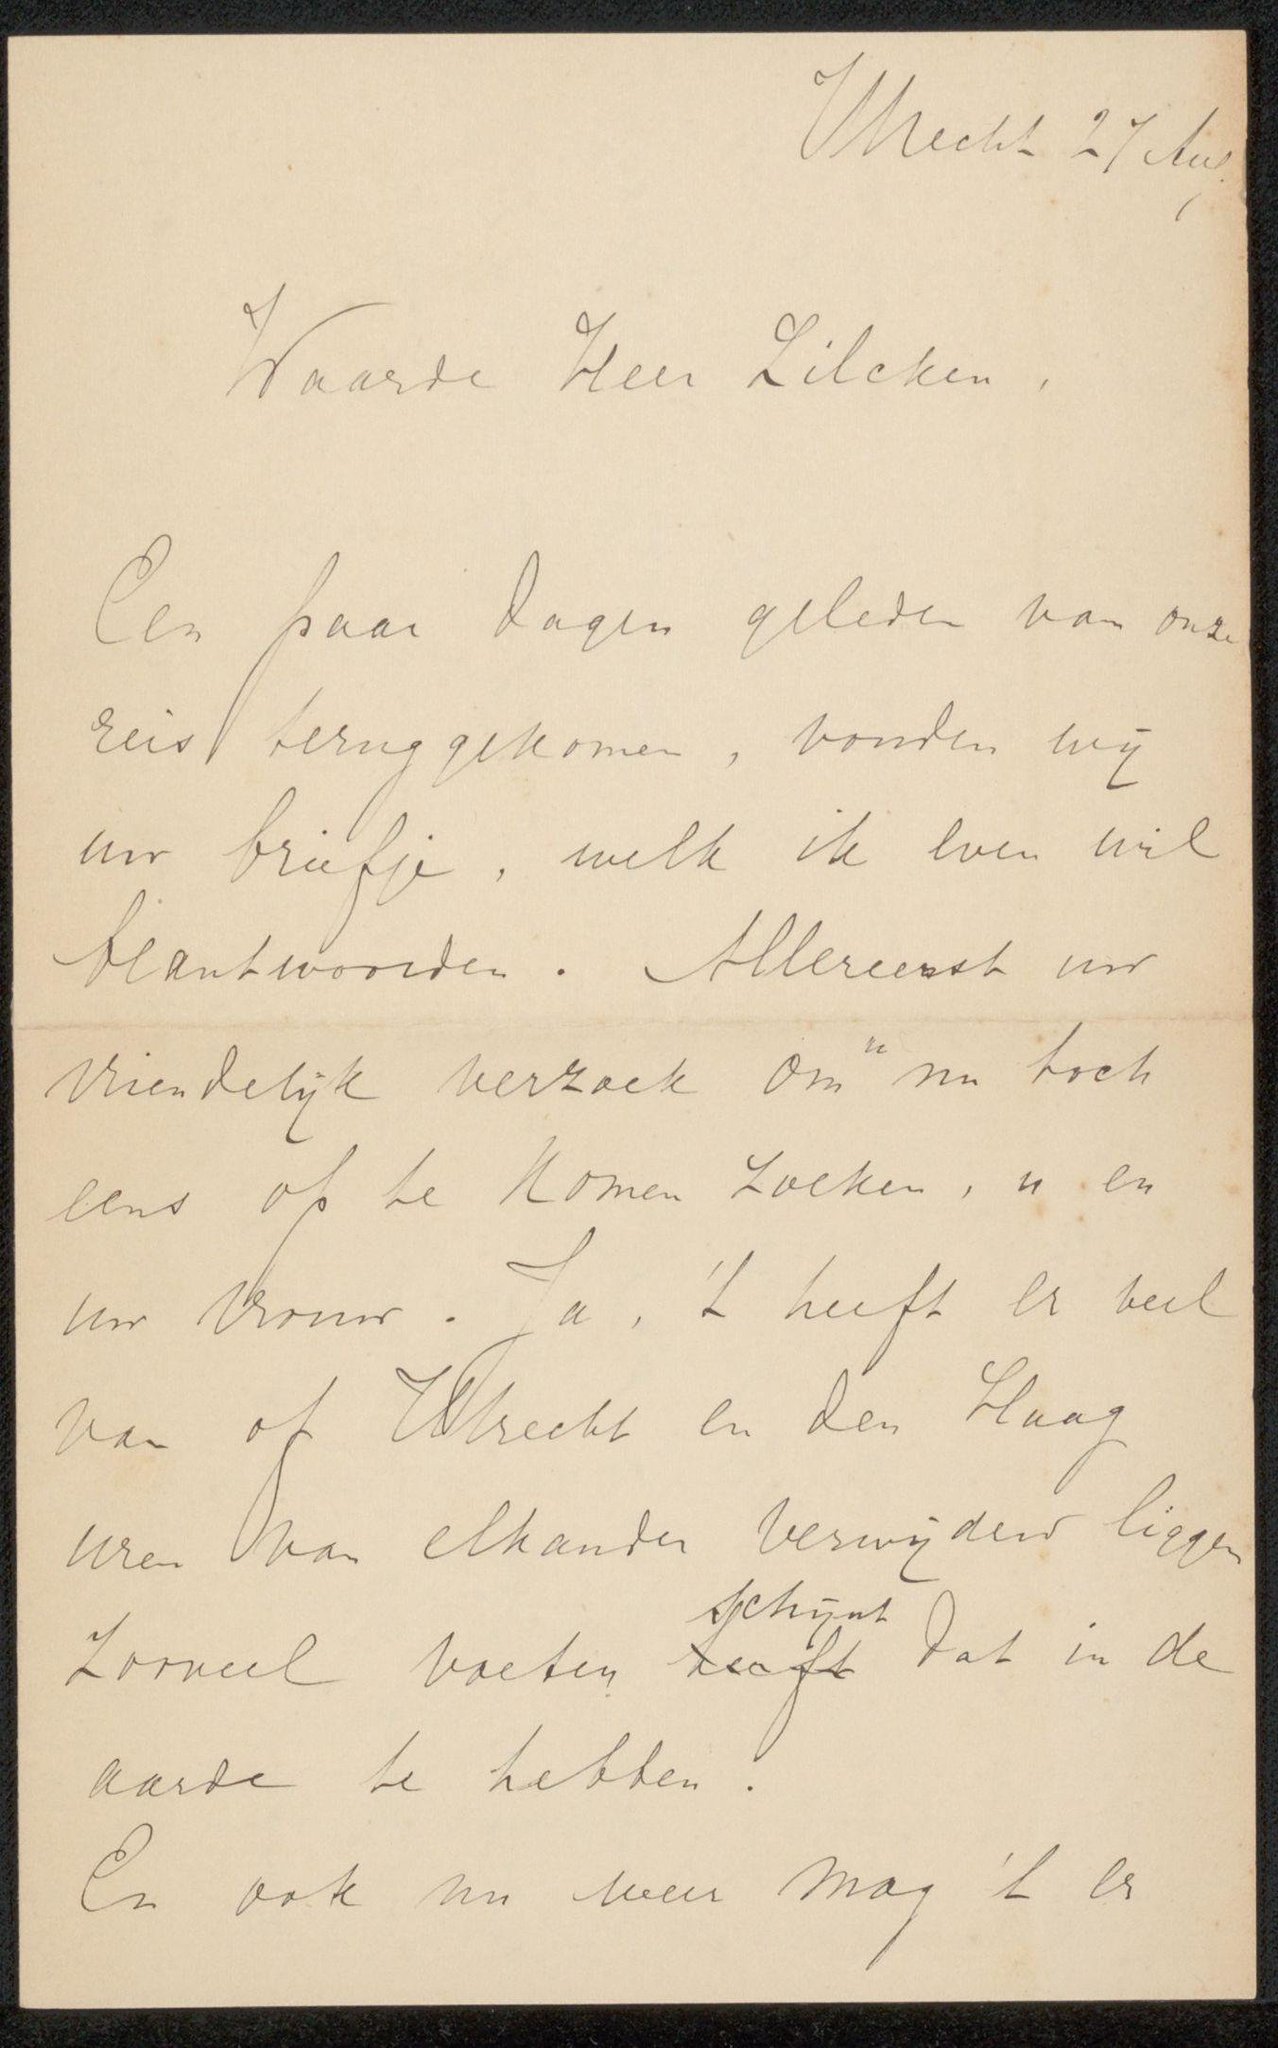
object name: letter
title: Brief aan Philip Zilcken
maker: anna singels-heintz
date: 1867-1930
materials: ink, paper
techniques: pen, writing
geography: utrecht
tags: the hague, painter, draughtsman, philip zilcken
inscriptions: collector's mark: ‘RPK’